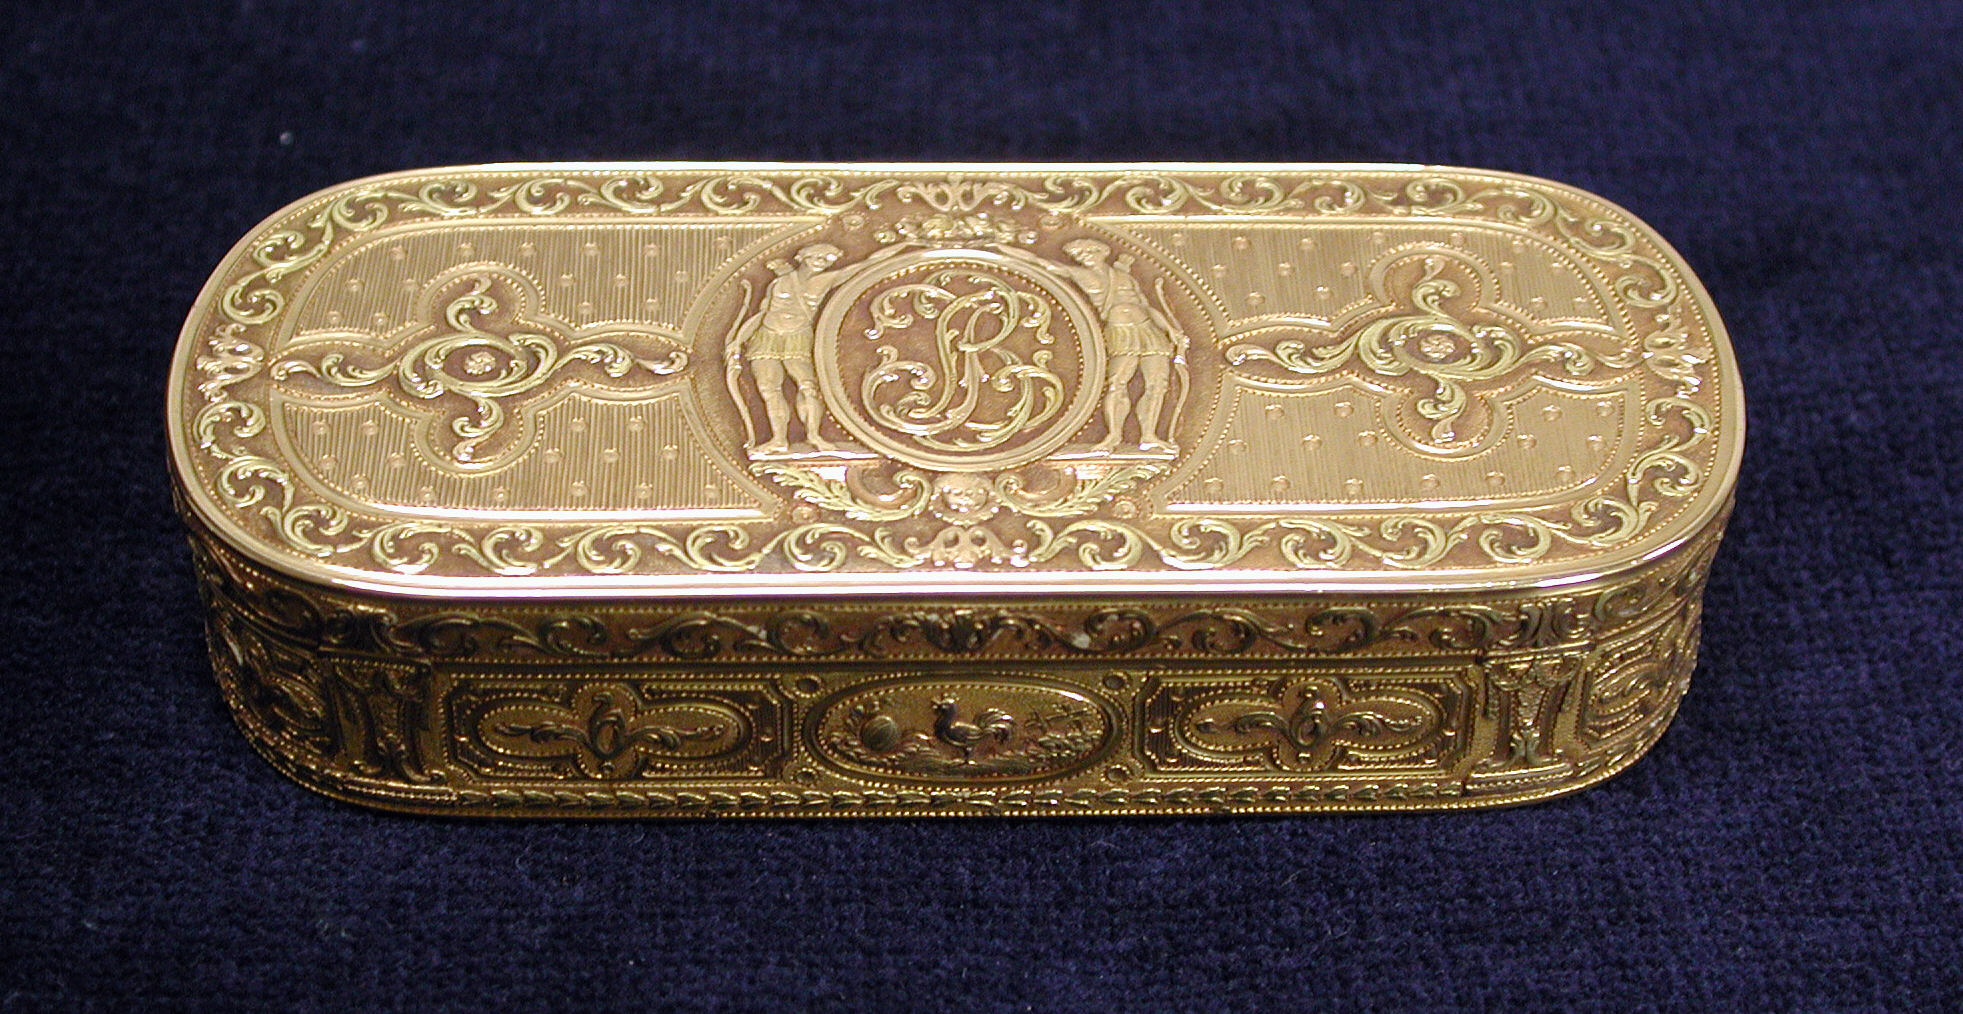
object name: box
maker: pierre blanchard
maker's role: maker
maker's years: 1725-1825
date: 1775-1781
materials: gold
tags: men,roosters,insignia